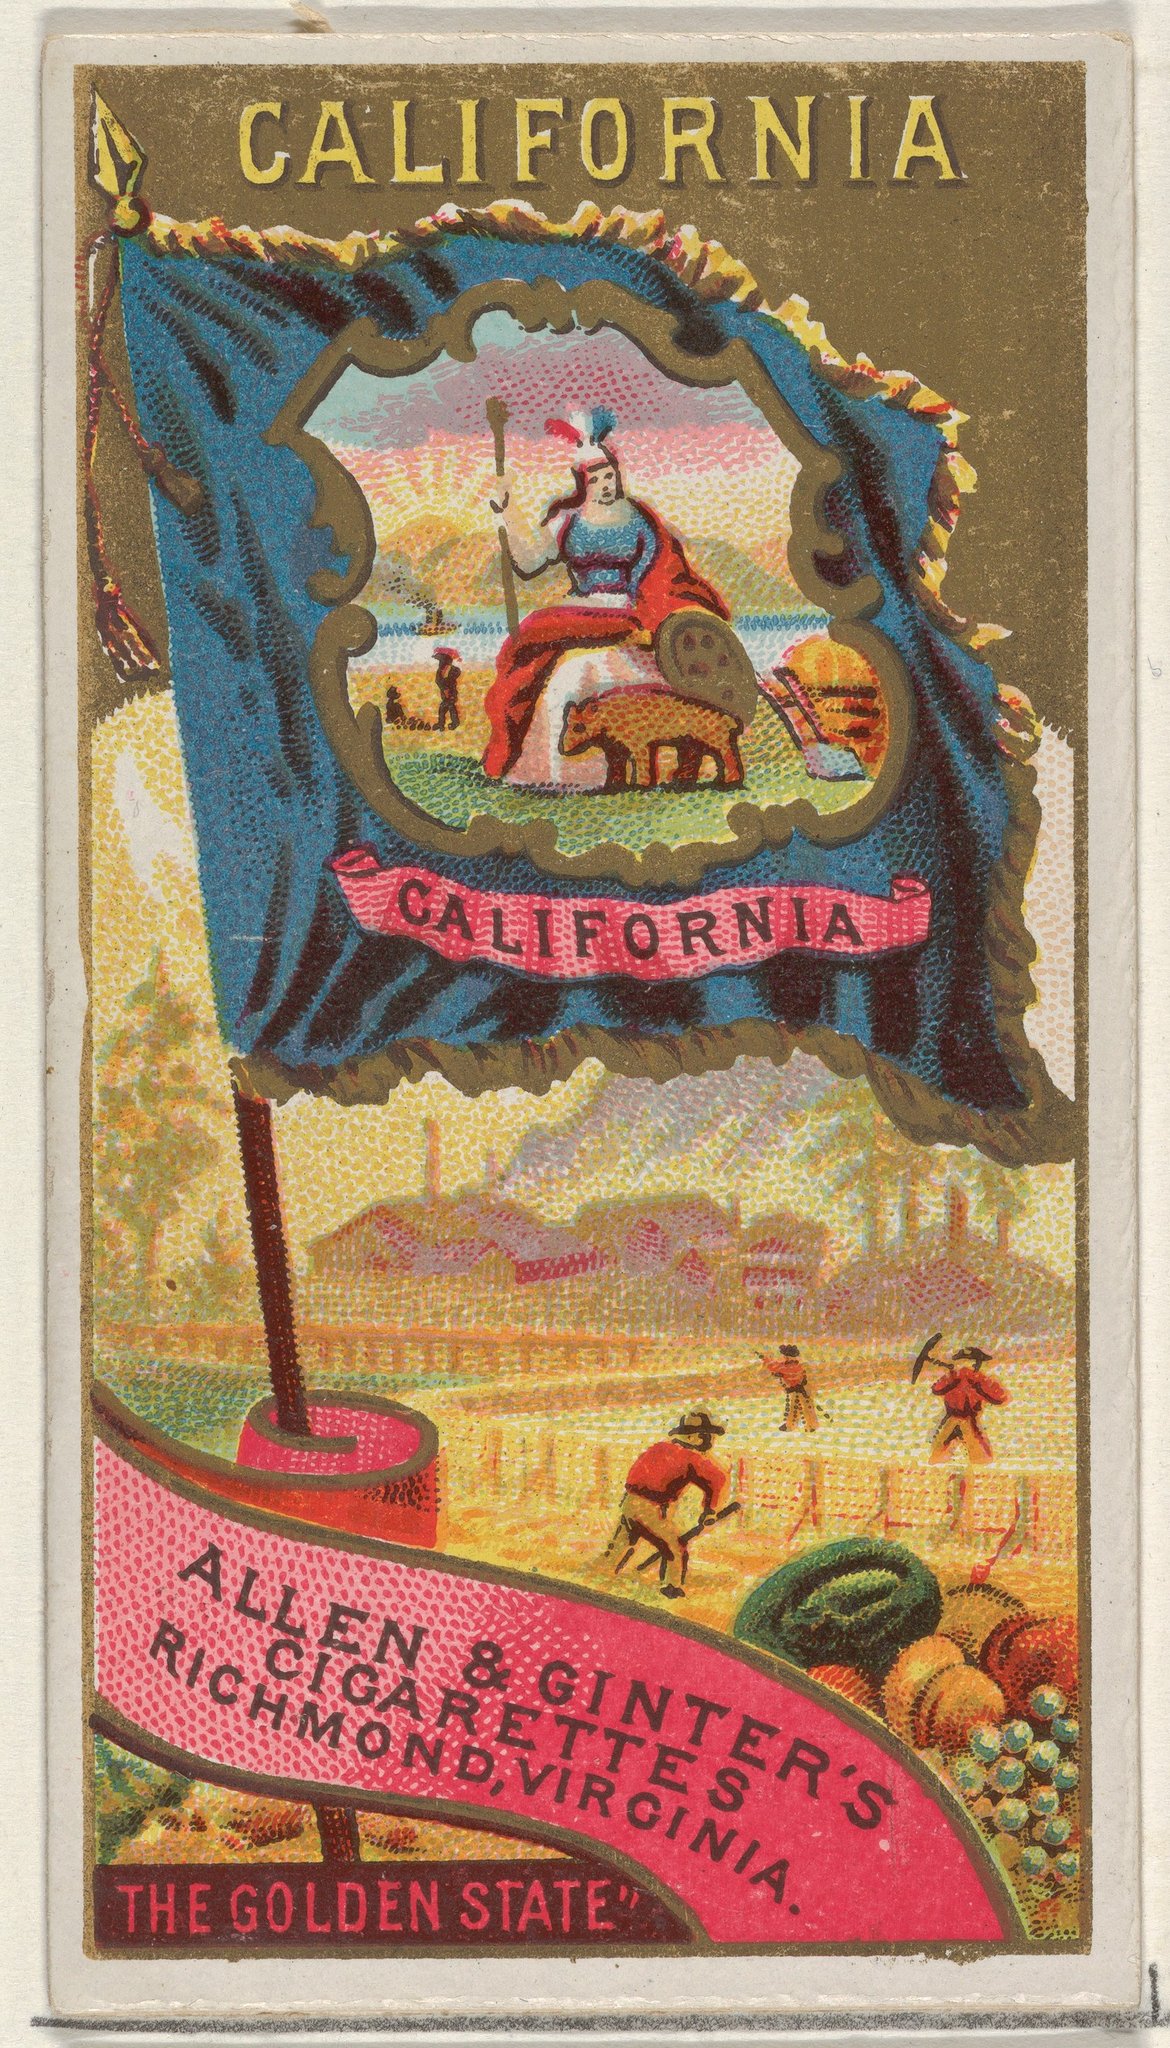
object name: print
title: California, from Flags of the States and Territories (N11) for Allen & Ginter Cigarettes Brands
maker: allen & ginter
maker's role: publisher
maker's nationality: american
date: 1888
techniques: color lithograph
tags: flags